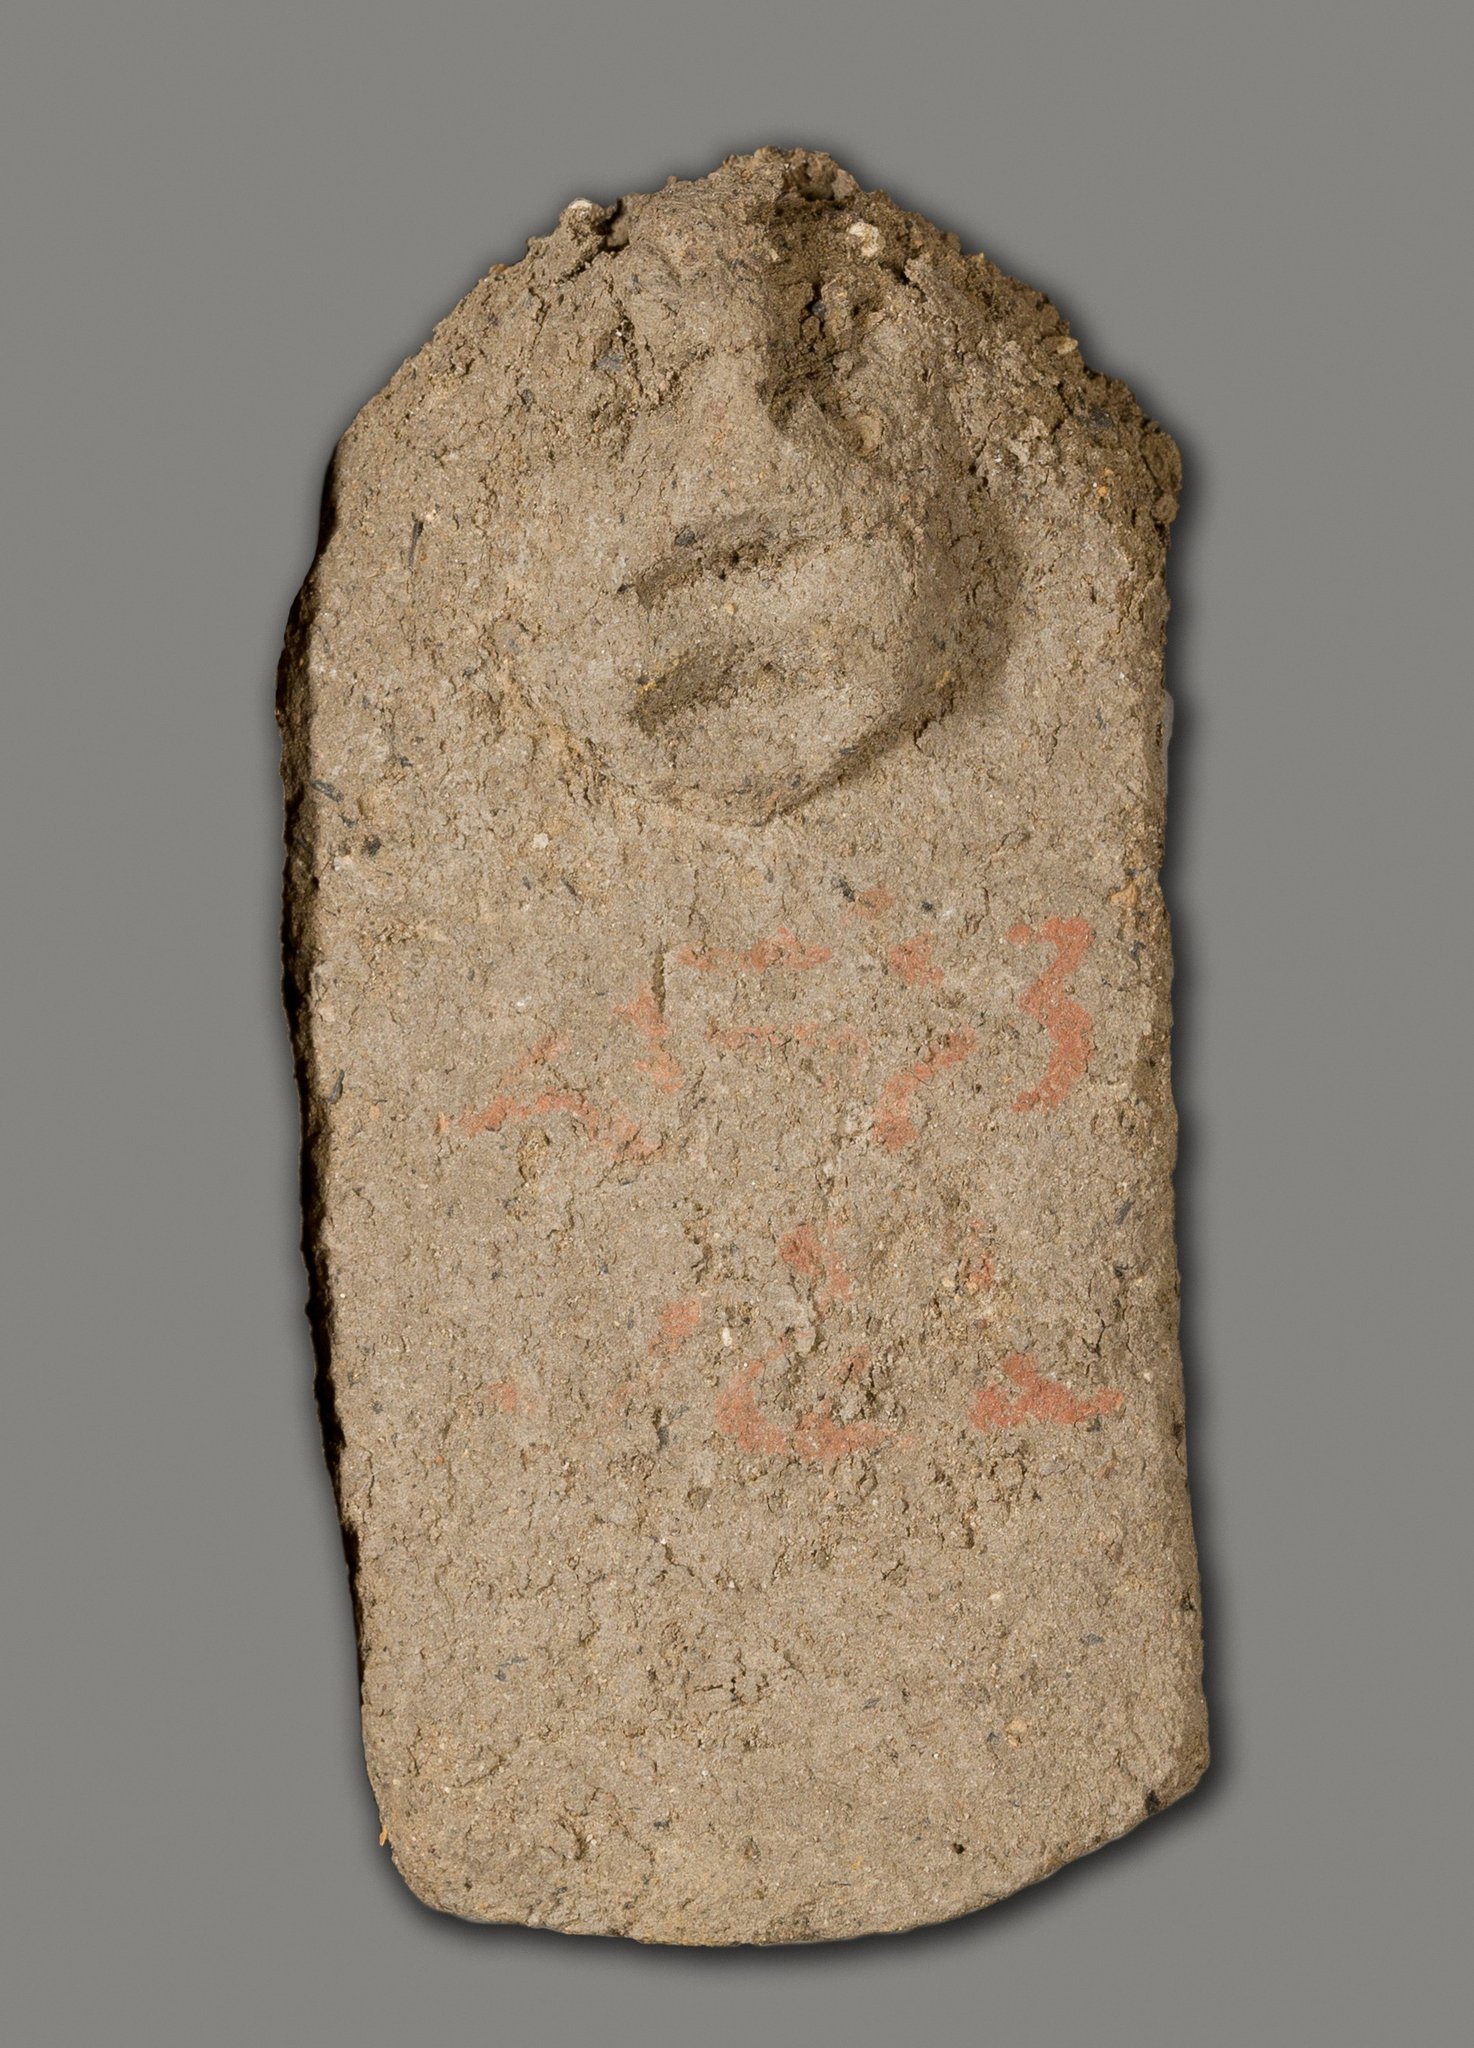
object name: figure, magical, execration, tablet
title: Magical Figure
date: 1802-1550 BCE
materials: clay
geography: egypt